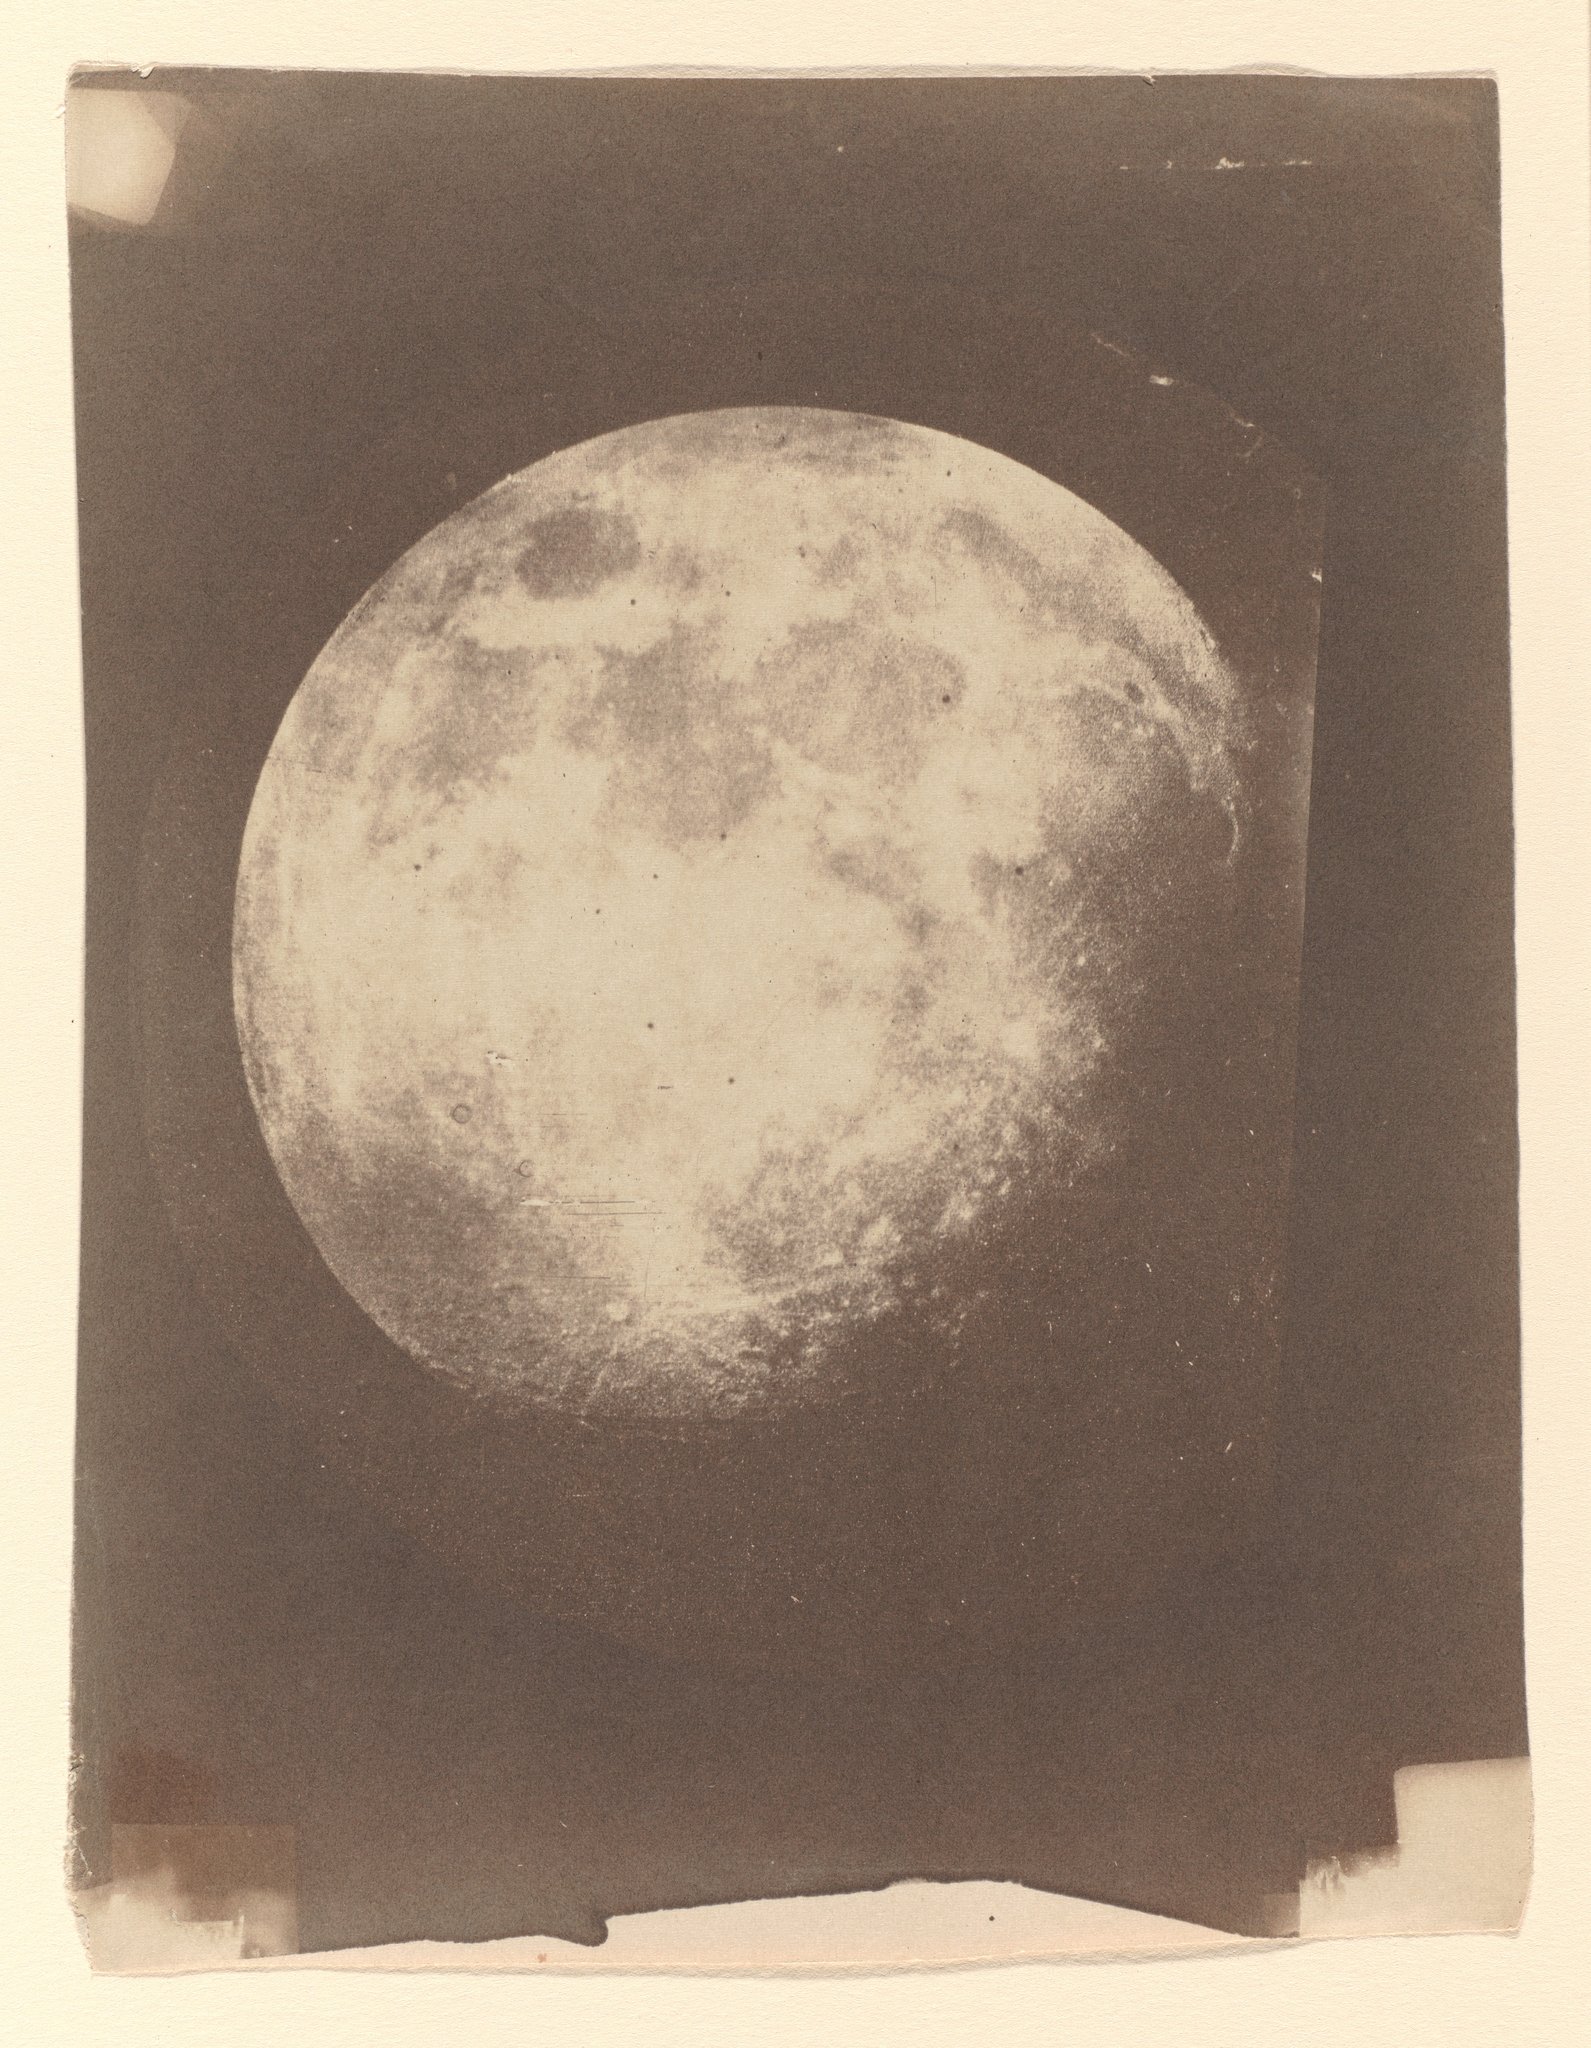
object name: photograph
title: The Moon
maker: john adams whipple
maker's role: artist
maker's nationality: american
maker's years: 1822-1891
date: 1857-1860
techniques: glass negative, salted paper print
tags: moon,astronomy